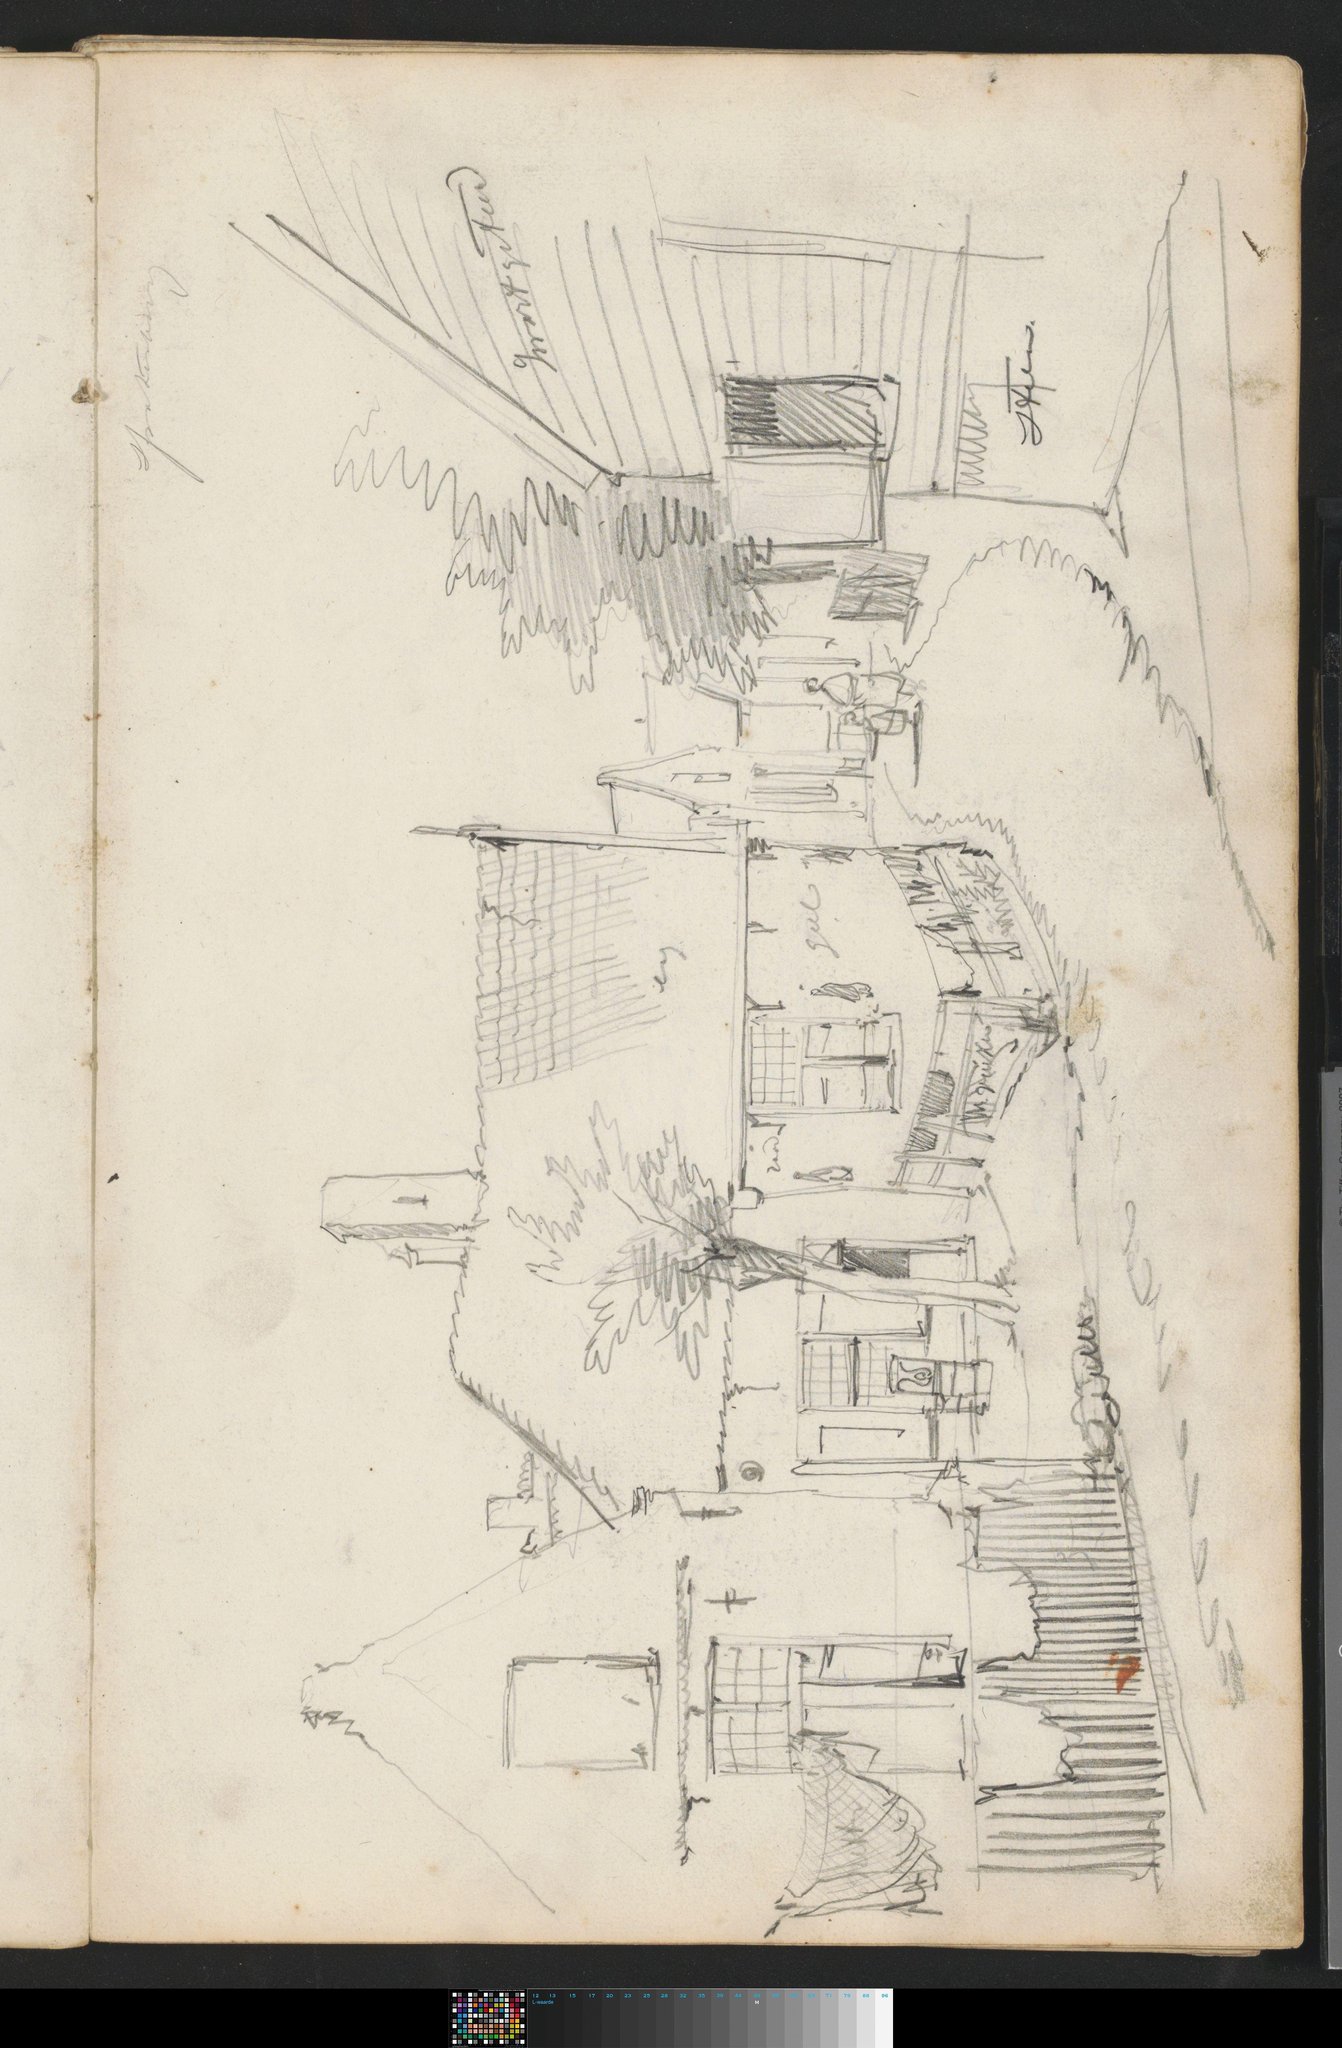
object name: sketchbook leaf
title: Straat met figuren te Spakenburg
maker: willem koekkoek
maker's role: draughtsman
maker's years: 1839-1895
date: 1849-1895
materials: paper, pencil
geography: spakenburg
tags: street (+ city(-scape) with figures, staffage)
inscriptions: annotation: ‘Spakenburg/ steen’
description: Blad 5 recto uit een schetsboek met 42 bladen.